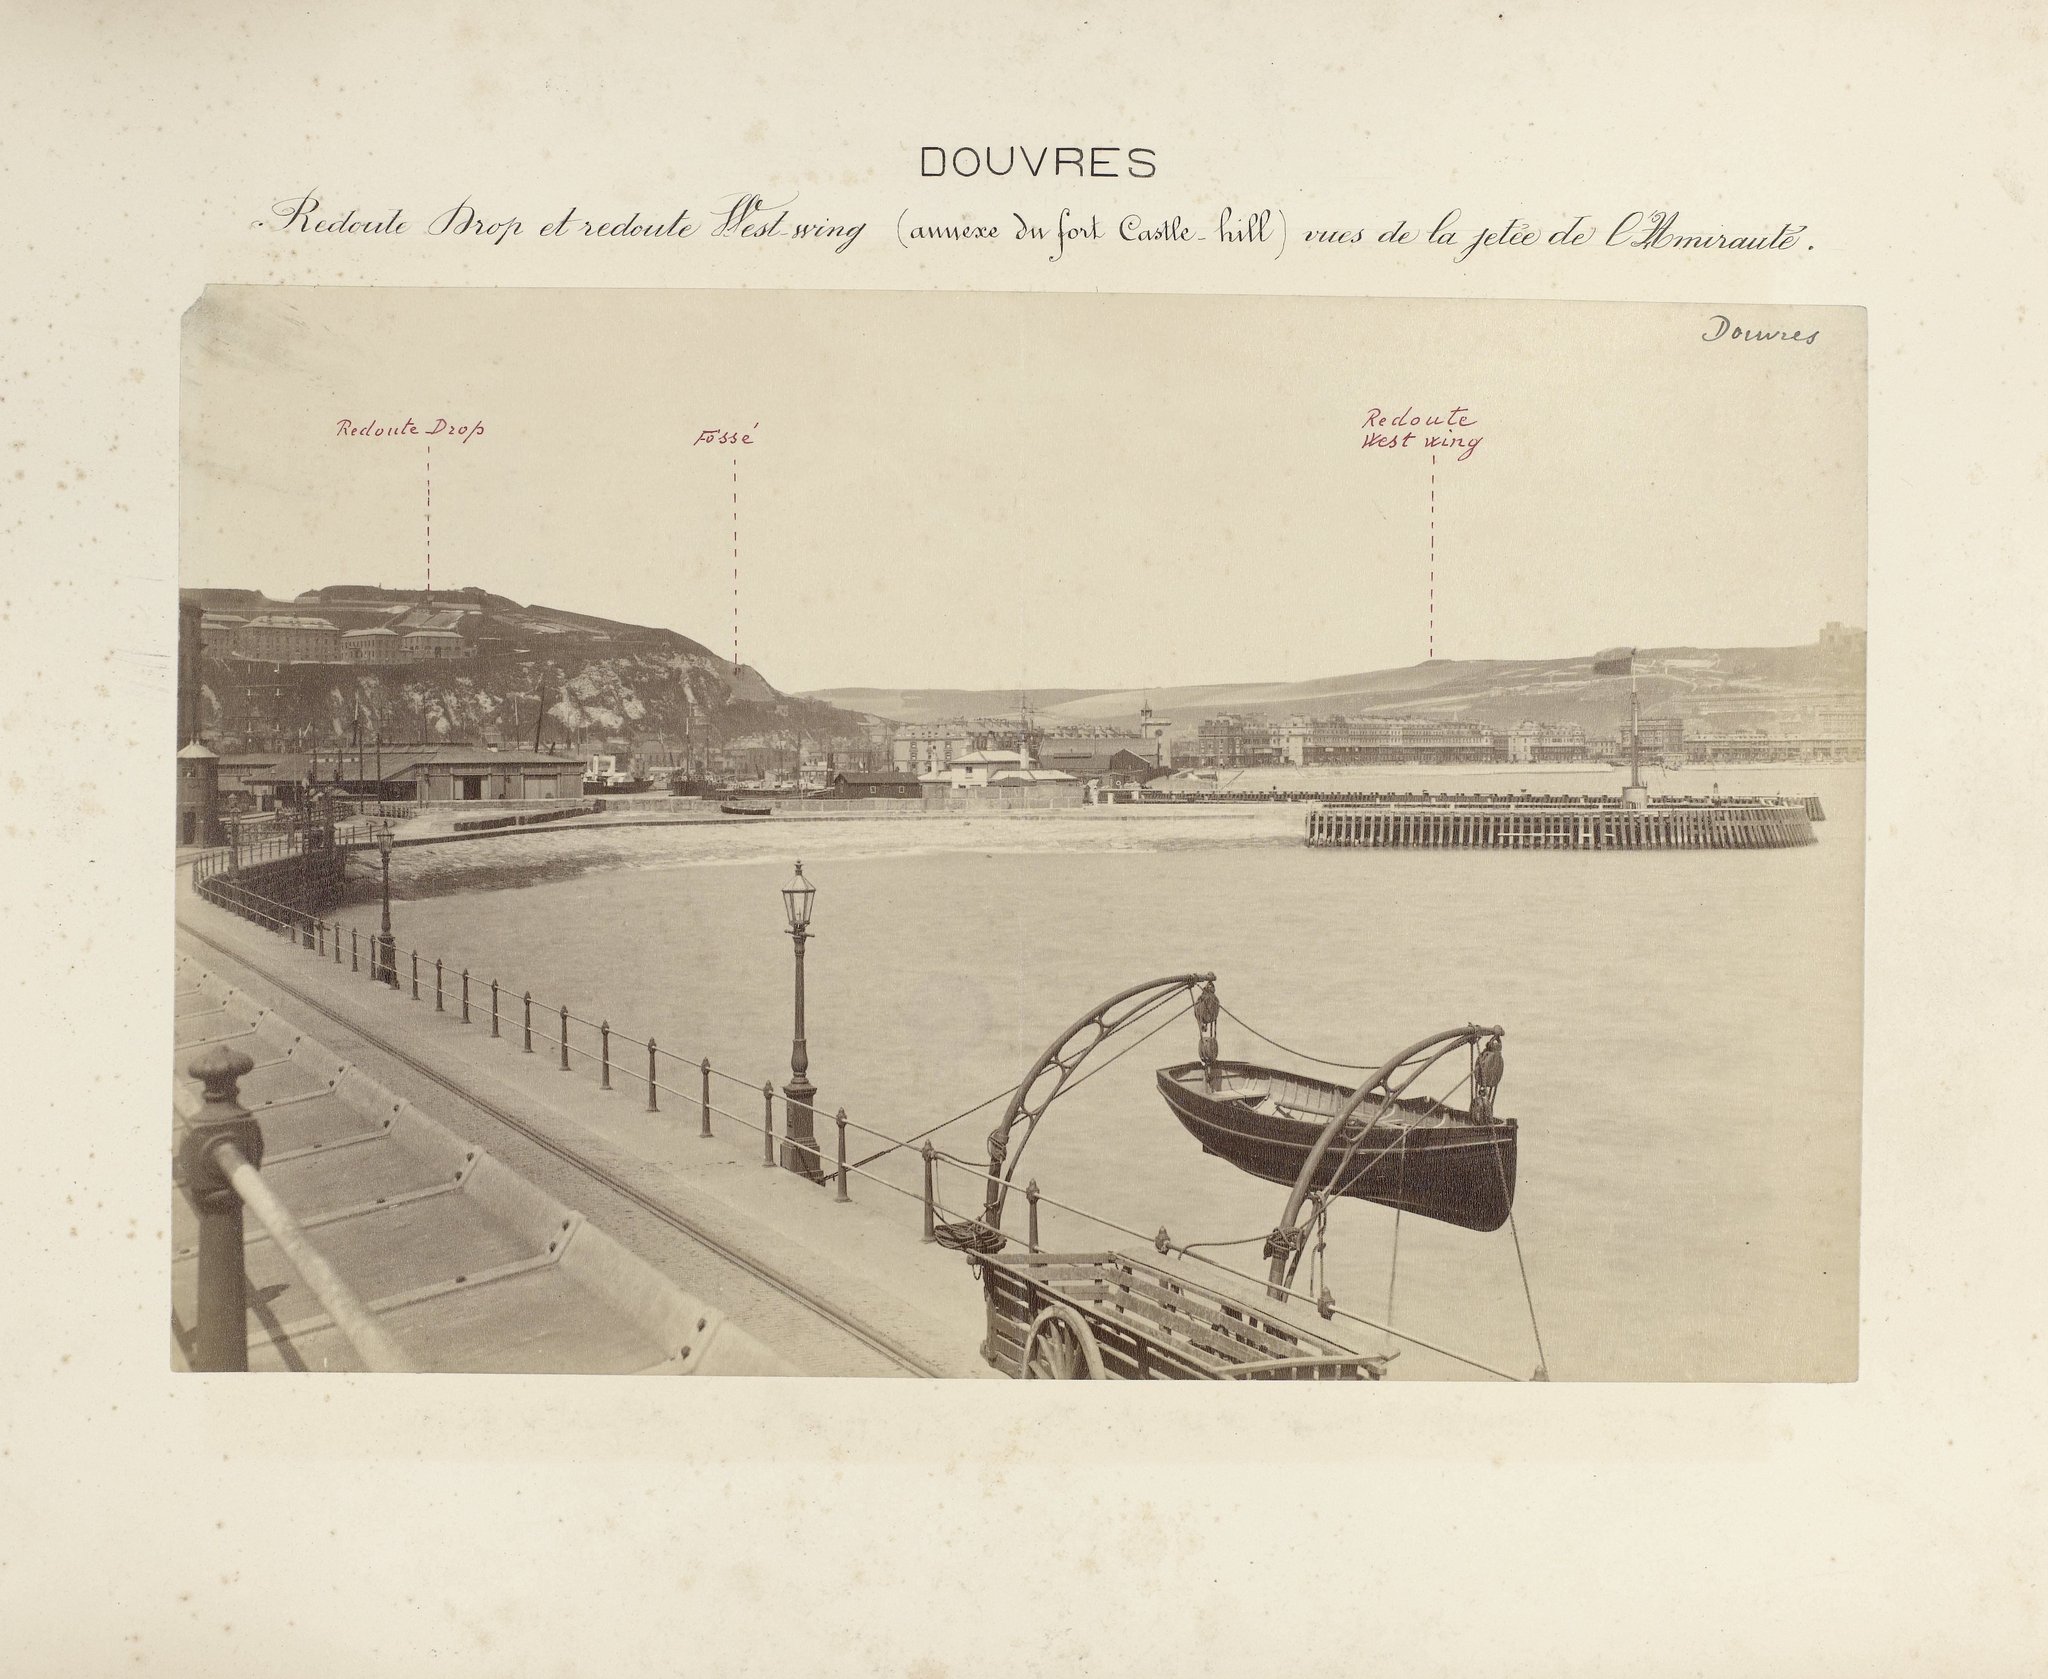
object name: photograph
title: Gezicht op Dover, gezien vanaf de pier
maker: Anonymous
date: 1891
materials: cardboard, paper, photographic support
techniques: albumen print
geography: great britain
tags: dover (engeland)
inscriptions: inscription: ‘DOUVRES / Redoute Drop et redoute West-wing (annexe du fort Castle-hill) vues de la jetée de l'Admirauté’, annotation: ‘Redoute Drop // Fossé // Redoute / West wing’, inscription: ‘Douvres’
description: Foto uit een album met 35 topografische foto's van Britse kustplaatsen, waarop in pen militaire verdedigingswerken zijn aangegeven door een Franse militair.